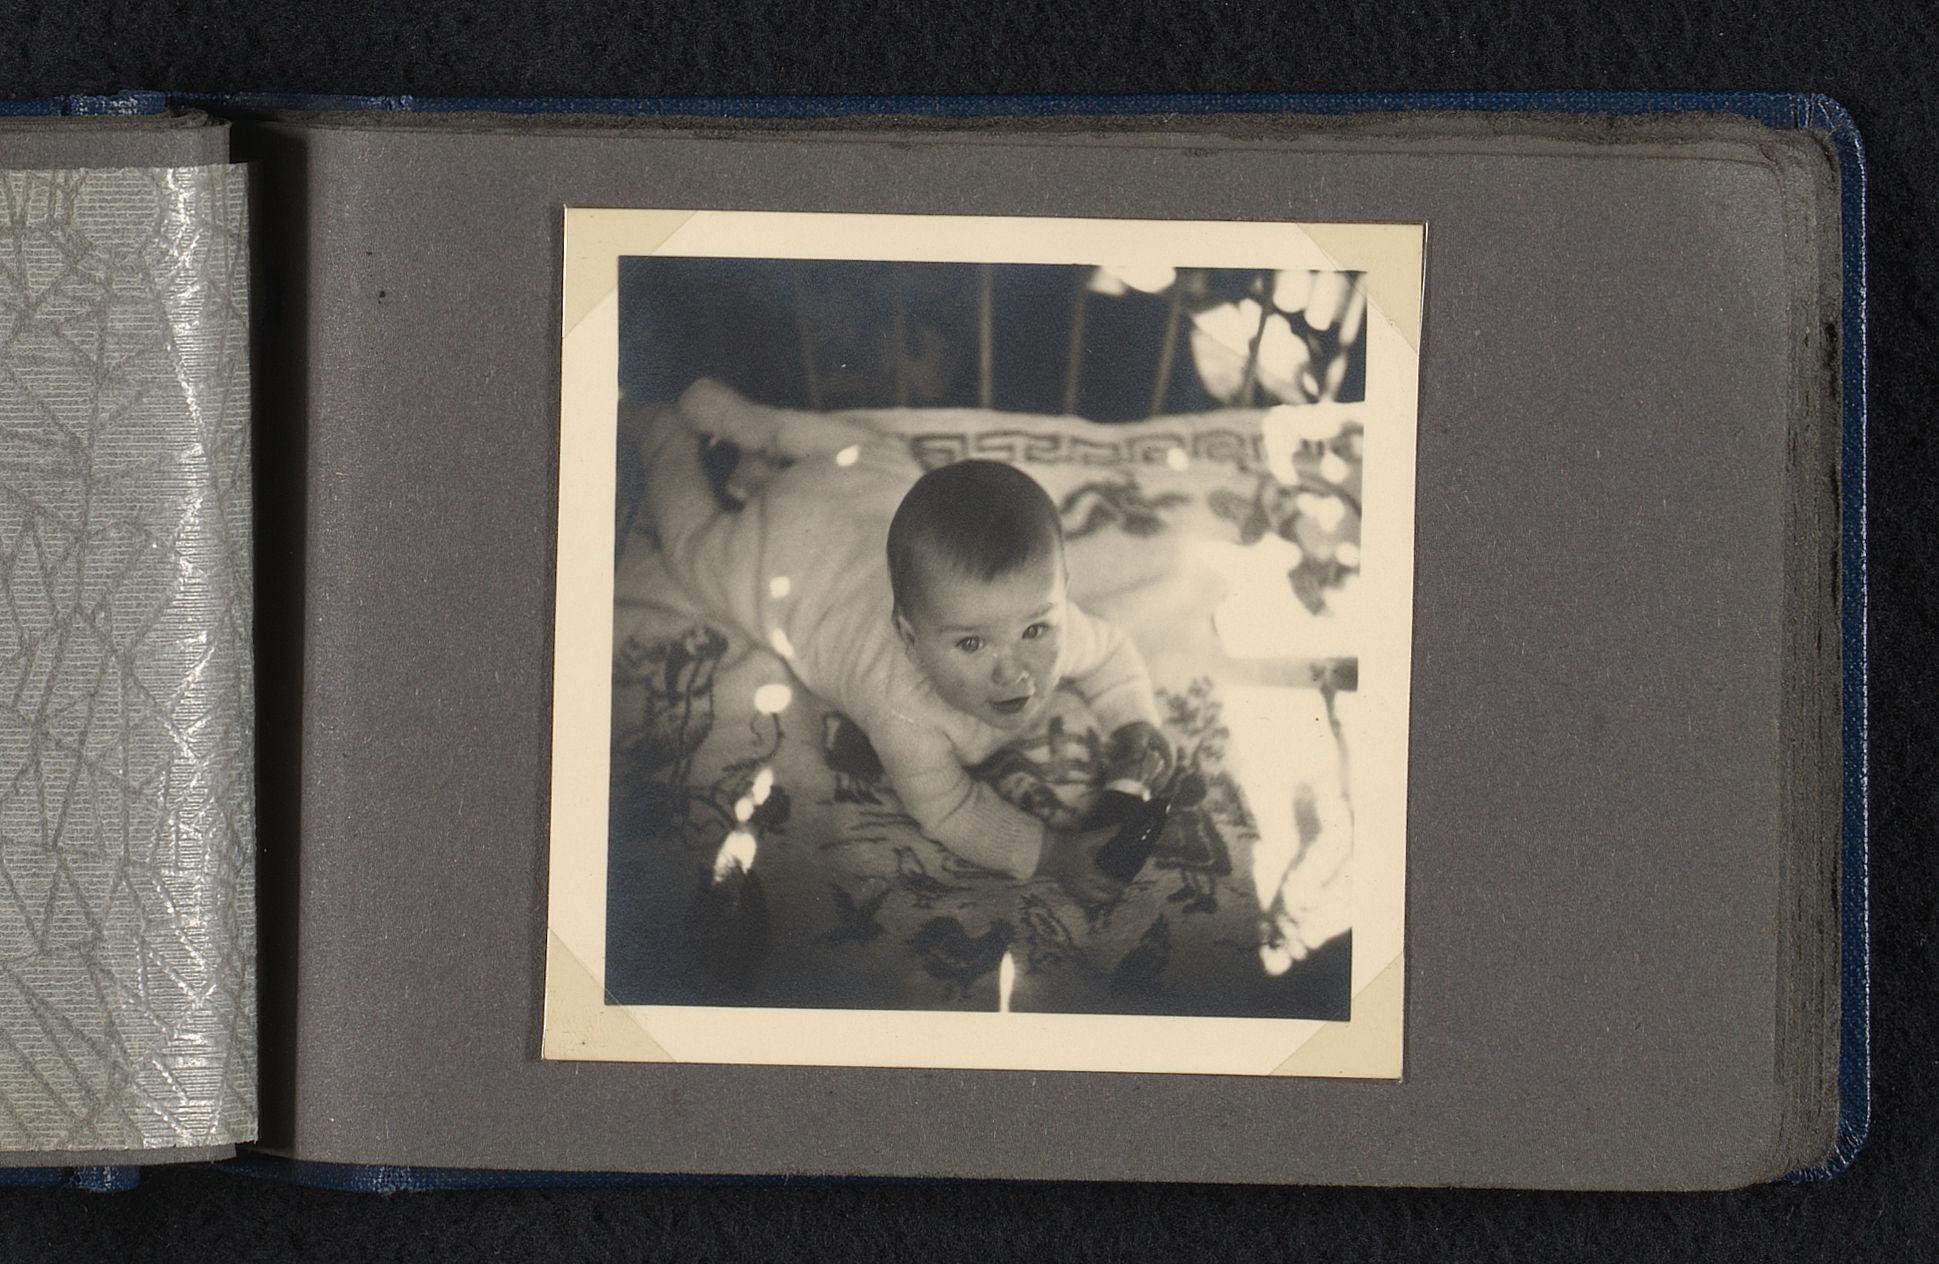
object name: photograph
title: Norbert Peter van den Berg als baby, gezien van boven, liggend op de buik op een kleed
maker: norbert peter van den berg (1941-)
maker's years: 1941-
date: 1941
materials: paper, cardboard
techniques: gelatin silver print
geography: netherlands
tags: amsterdam, norbert peter van den berg (1941-), infant, baby